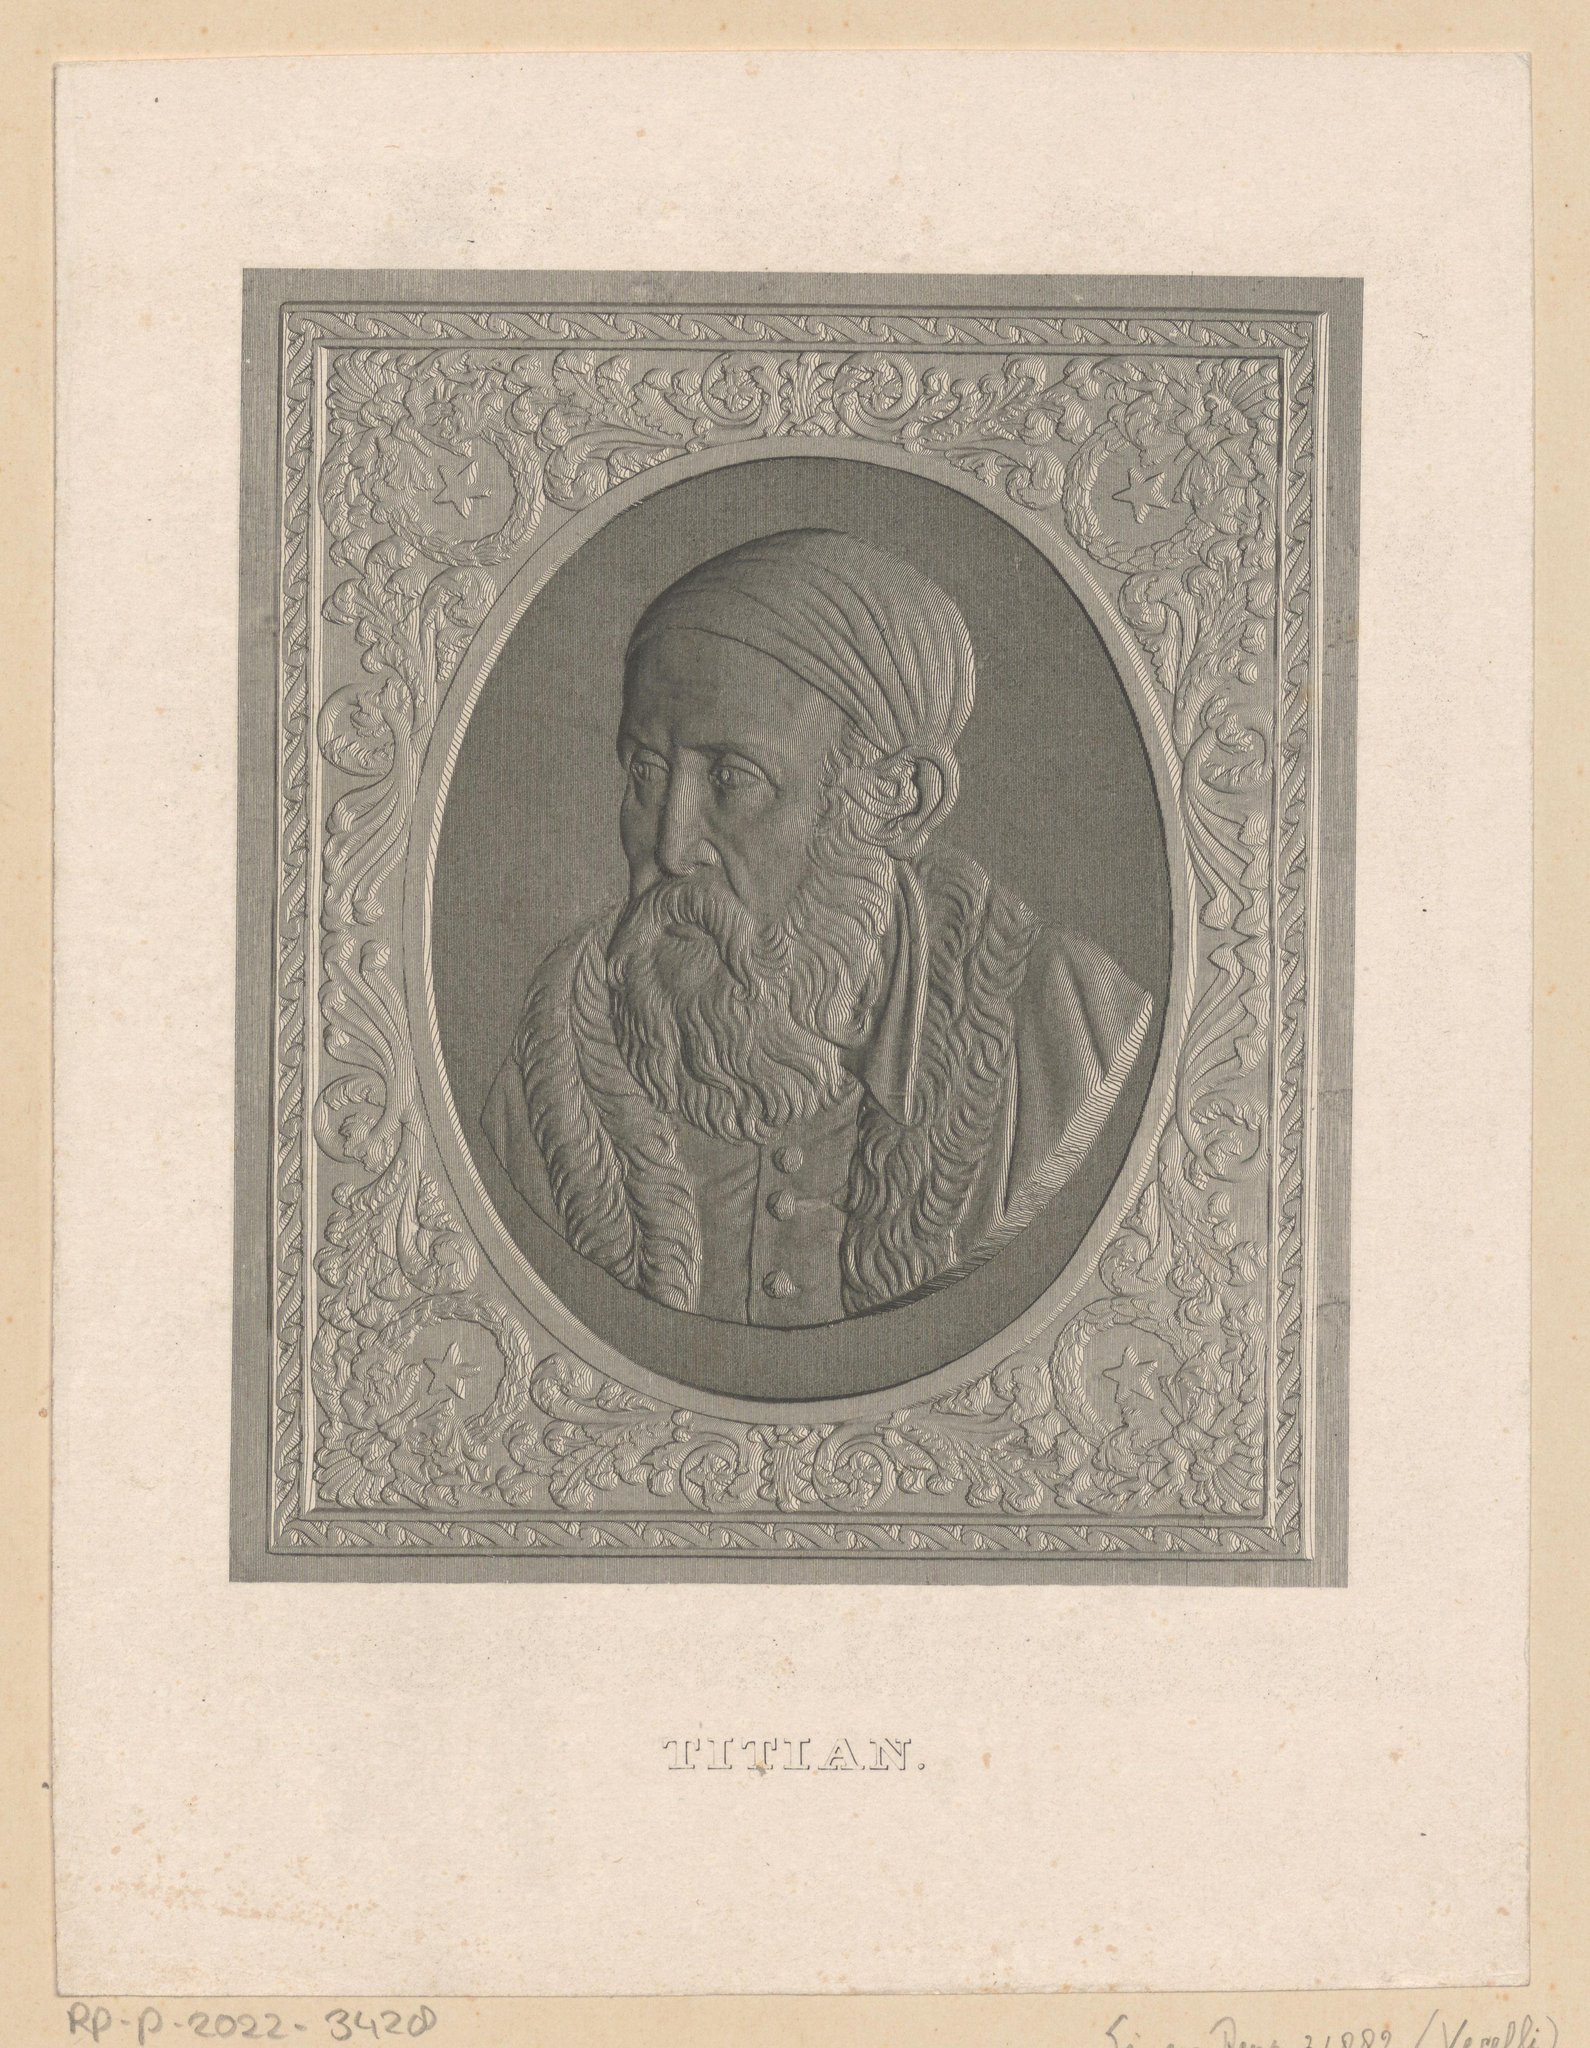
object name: print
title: Portret van Titiaan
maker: Anonymous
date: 1820-1899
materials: paper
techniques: engraving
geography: italy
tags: venice, draughtsman, titiaan, historical persons, portrait, self-portrait of artist